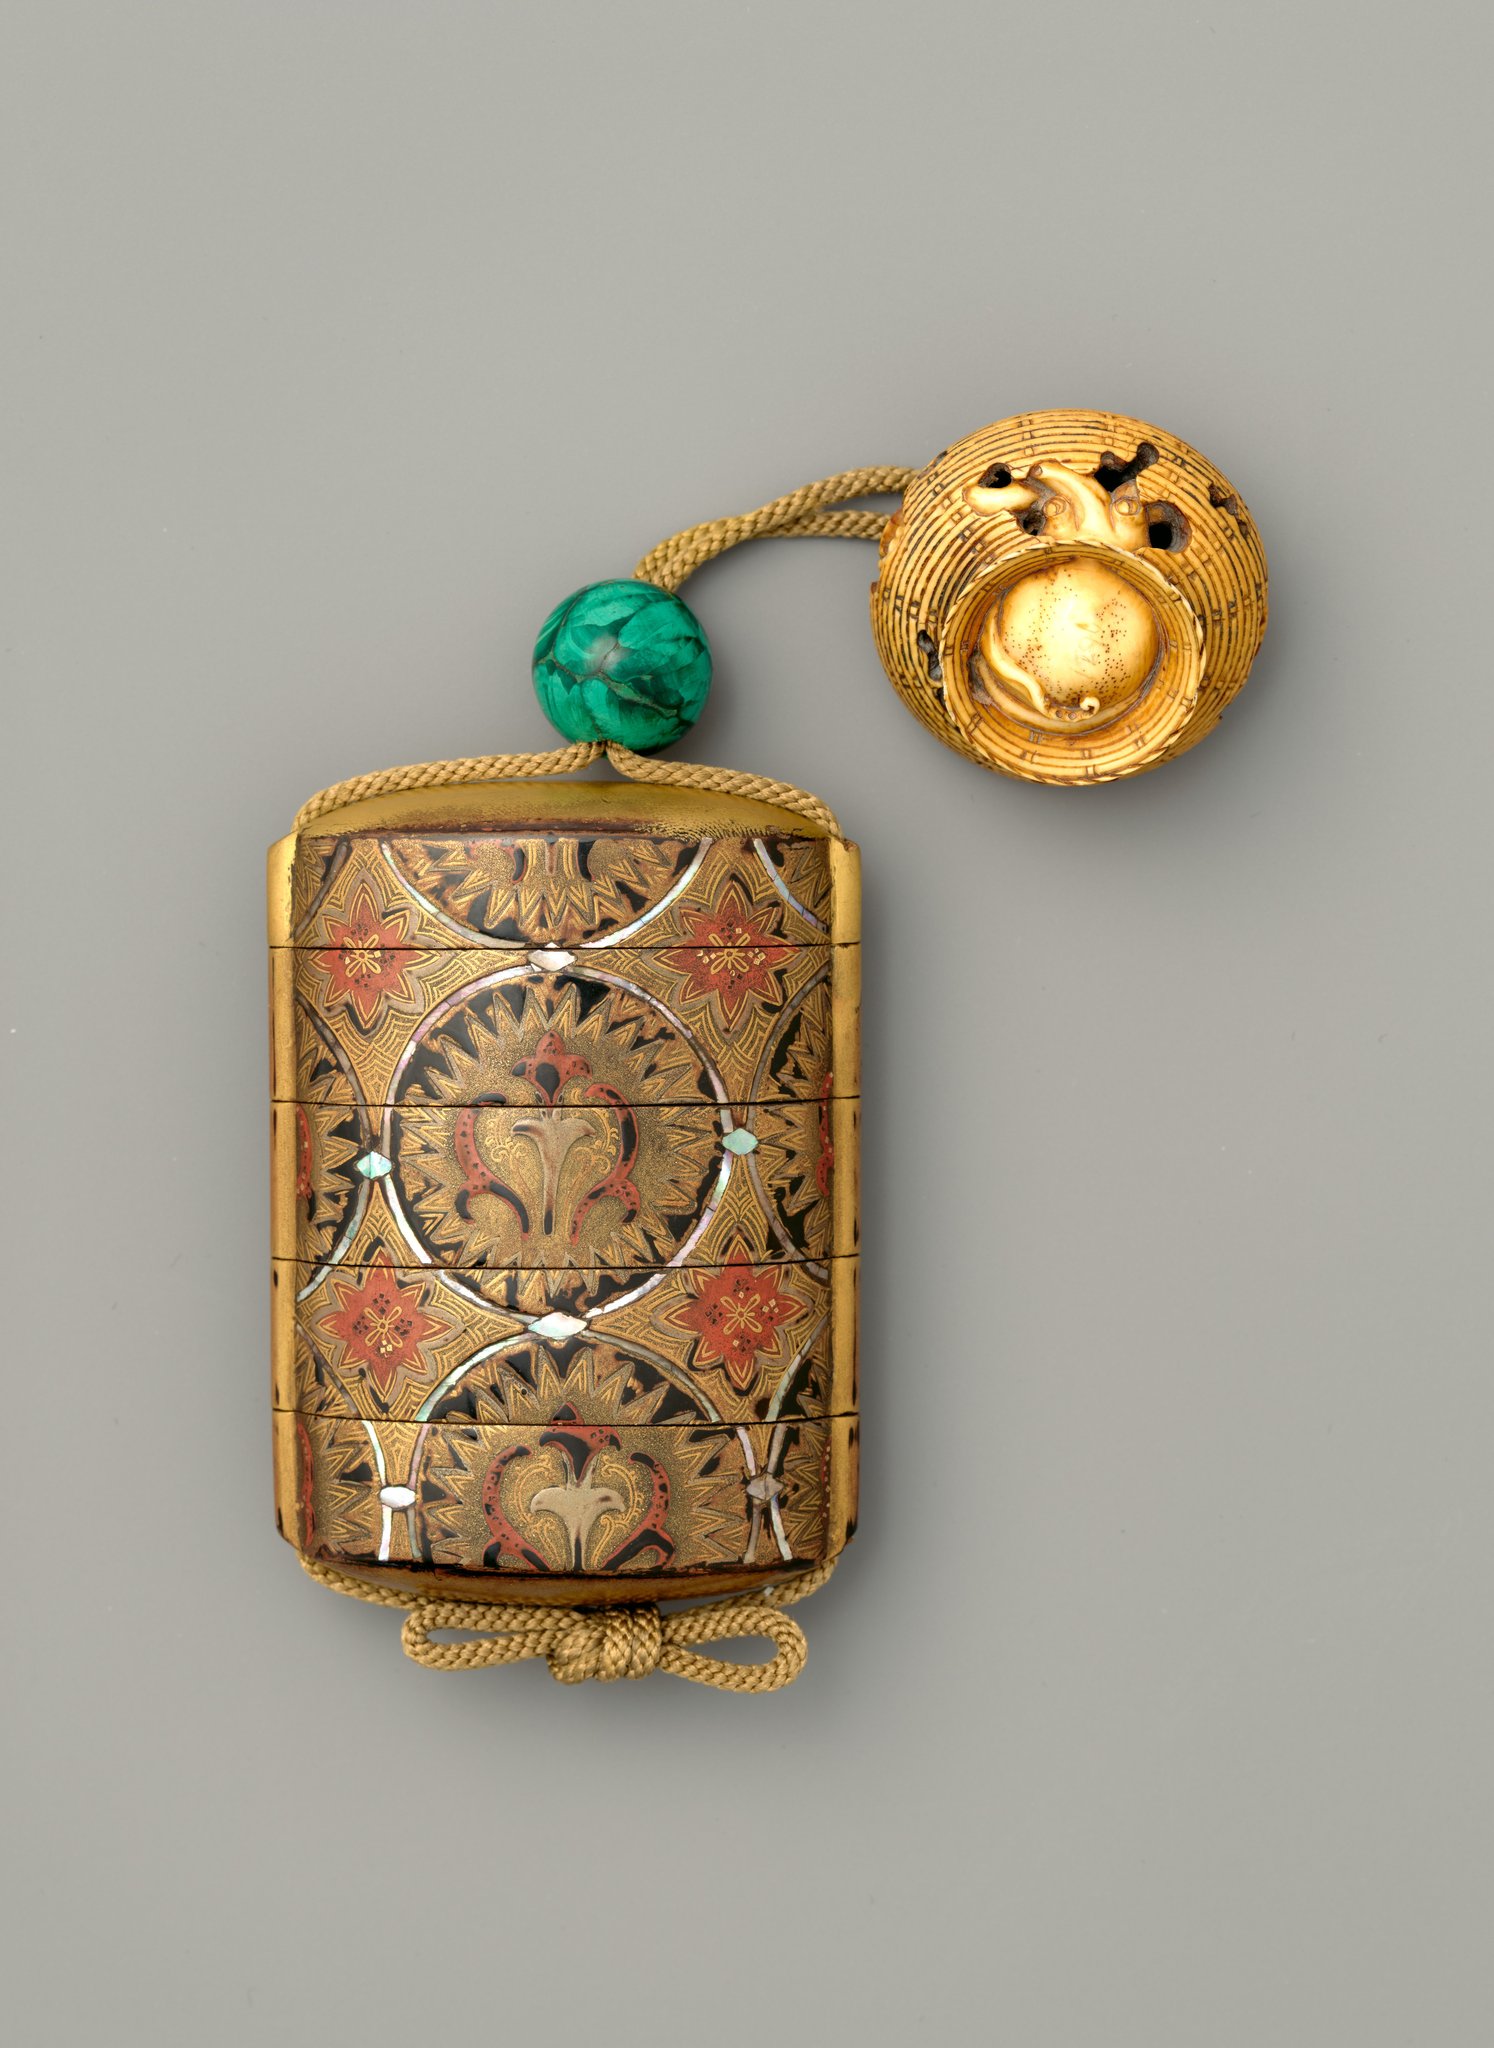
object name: inrō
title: Inrō with Stylized Flower Patterns in Interconnected Roundels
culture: japanese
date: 1701-1800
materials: gold, ivory, lacquer, mother of pearl, silver, wood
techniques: inlay, lacquer